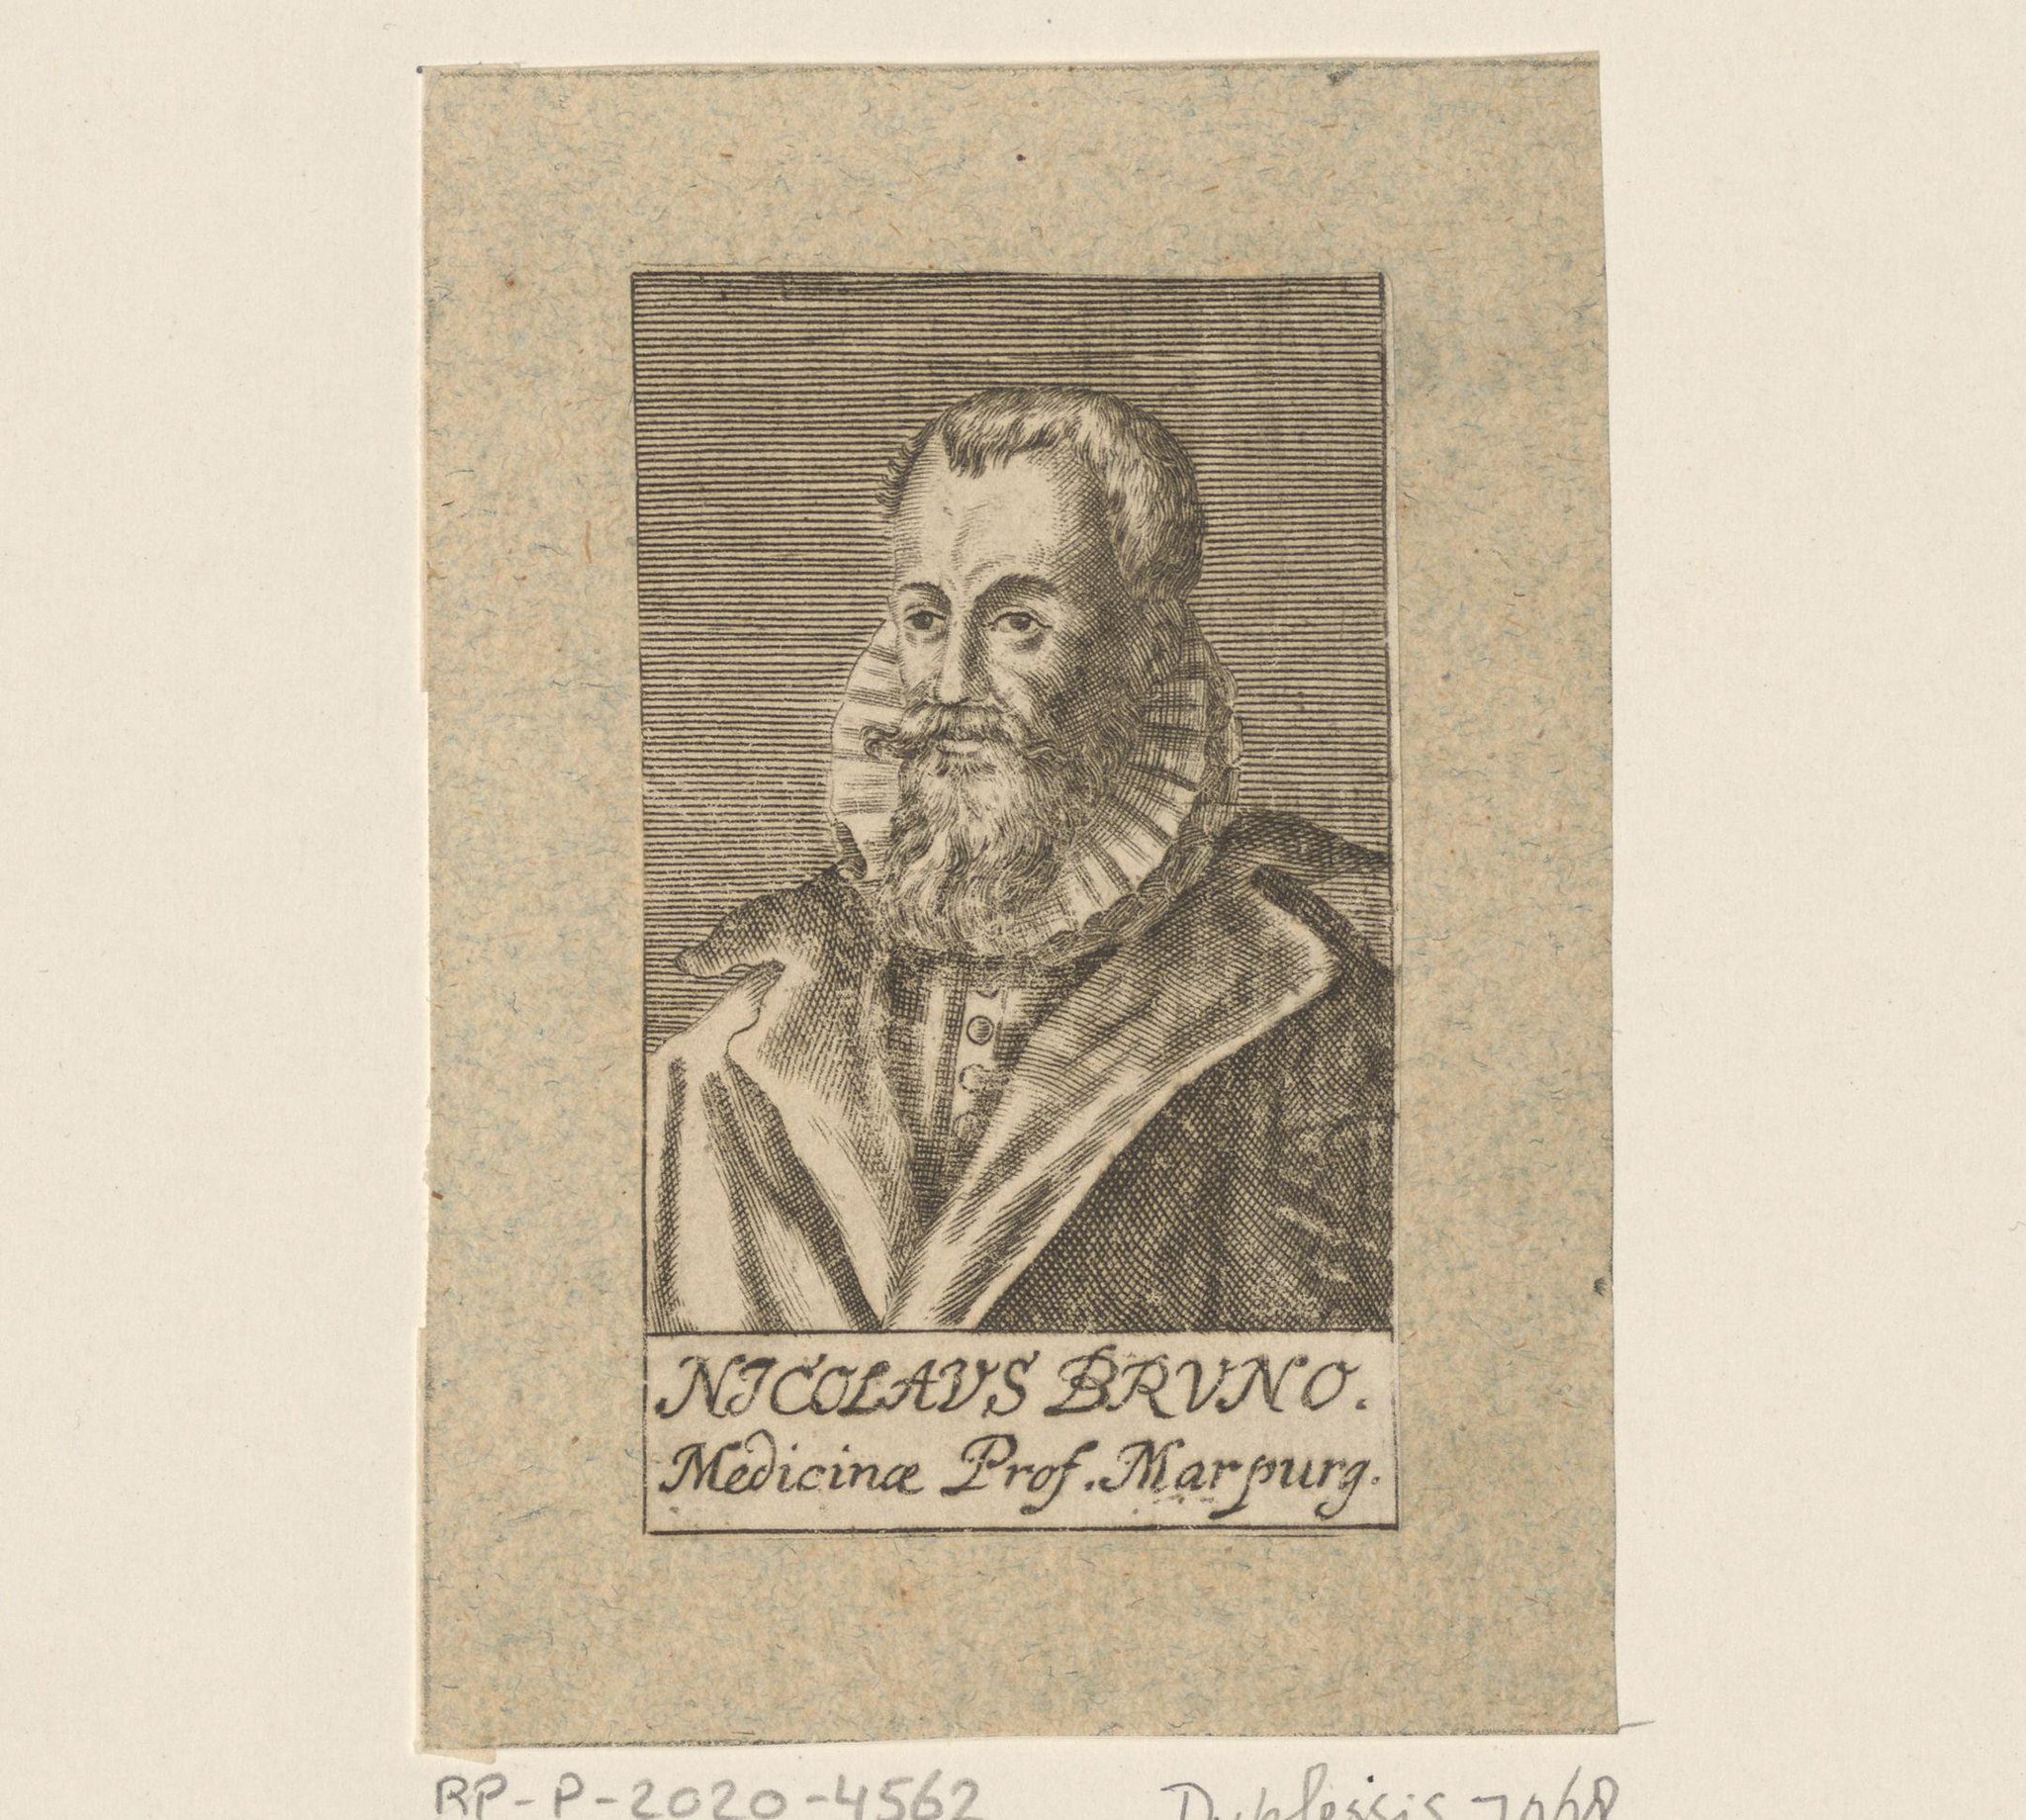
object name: print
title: Portret van Nicolaus Bruno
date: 1688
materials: paper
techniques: engraving, etching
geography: nuremberg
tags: historical persons, physician, doctor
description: Prent uit: Freher, Paul. Theatrum virorum eruditione clarorum. Neurenberg: Johann Hoffmann, 1688.